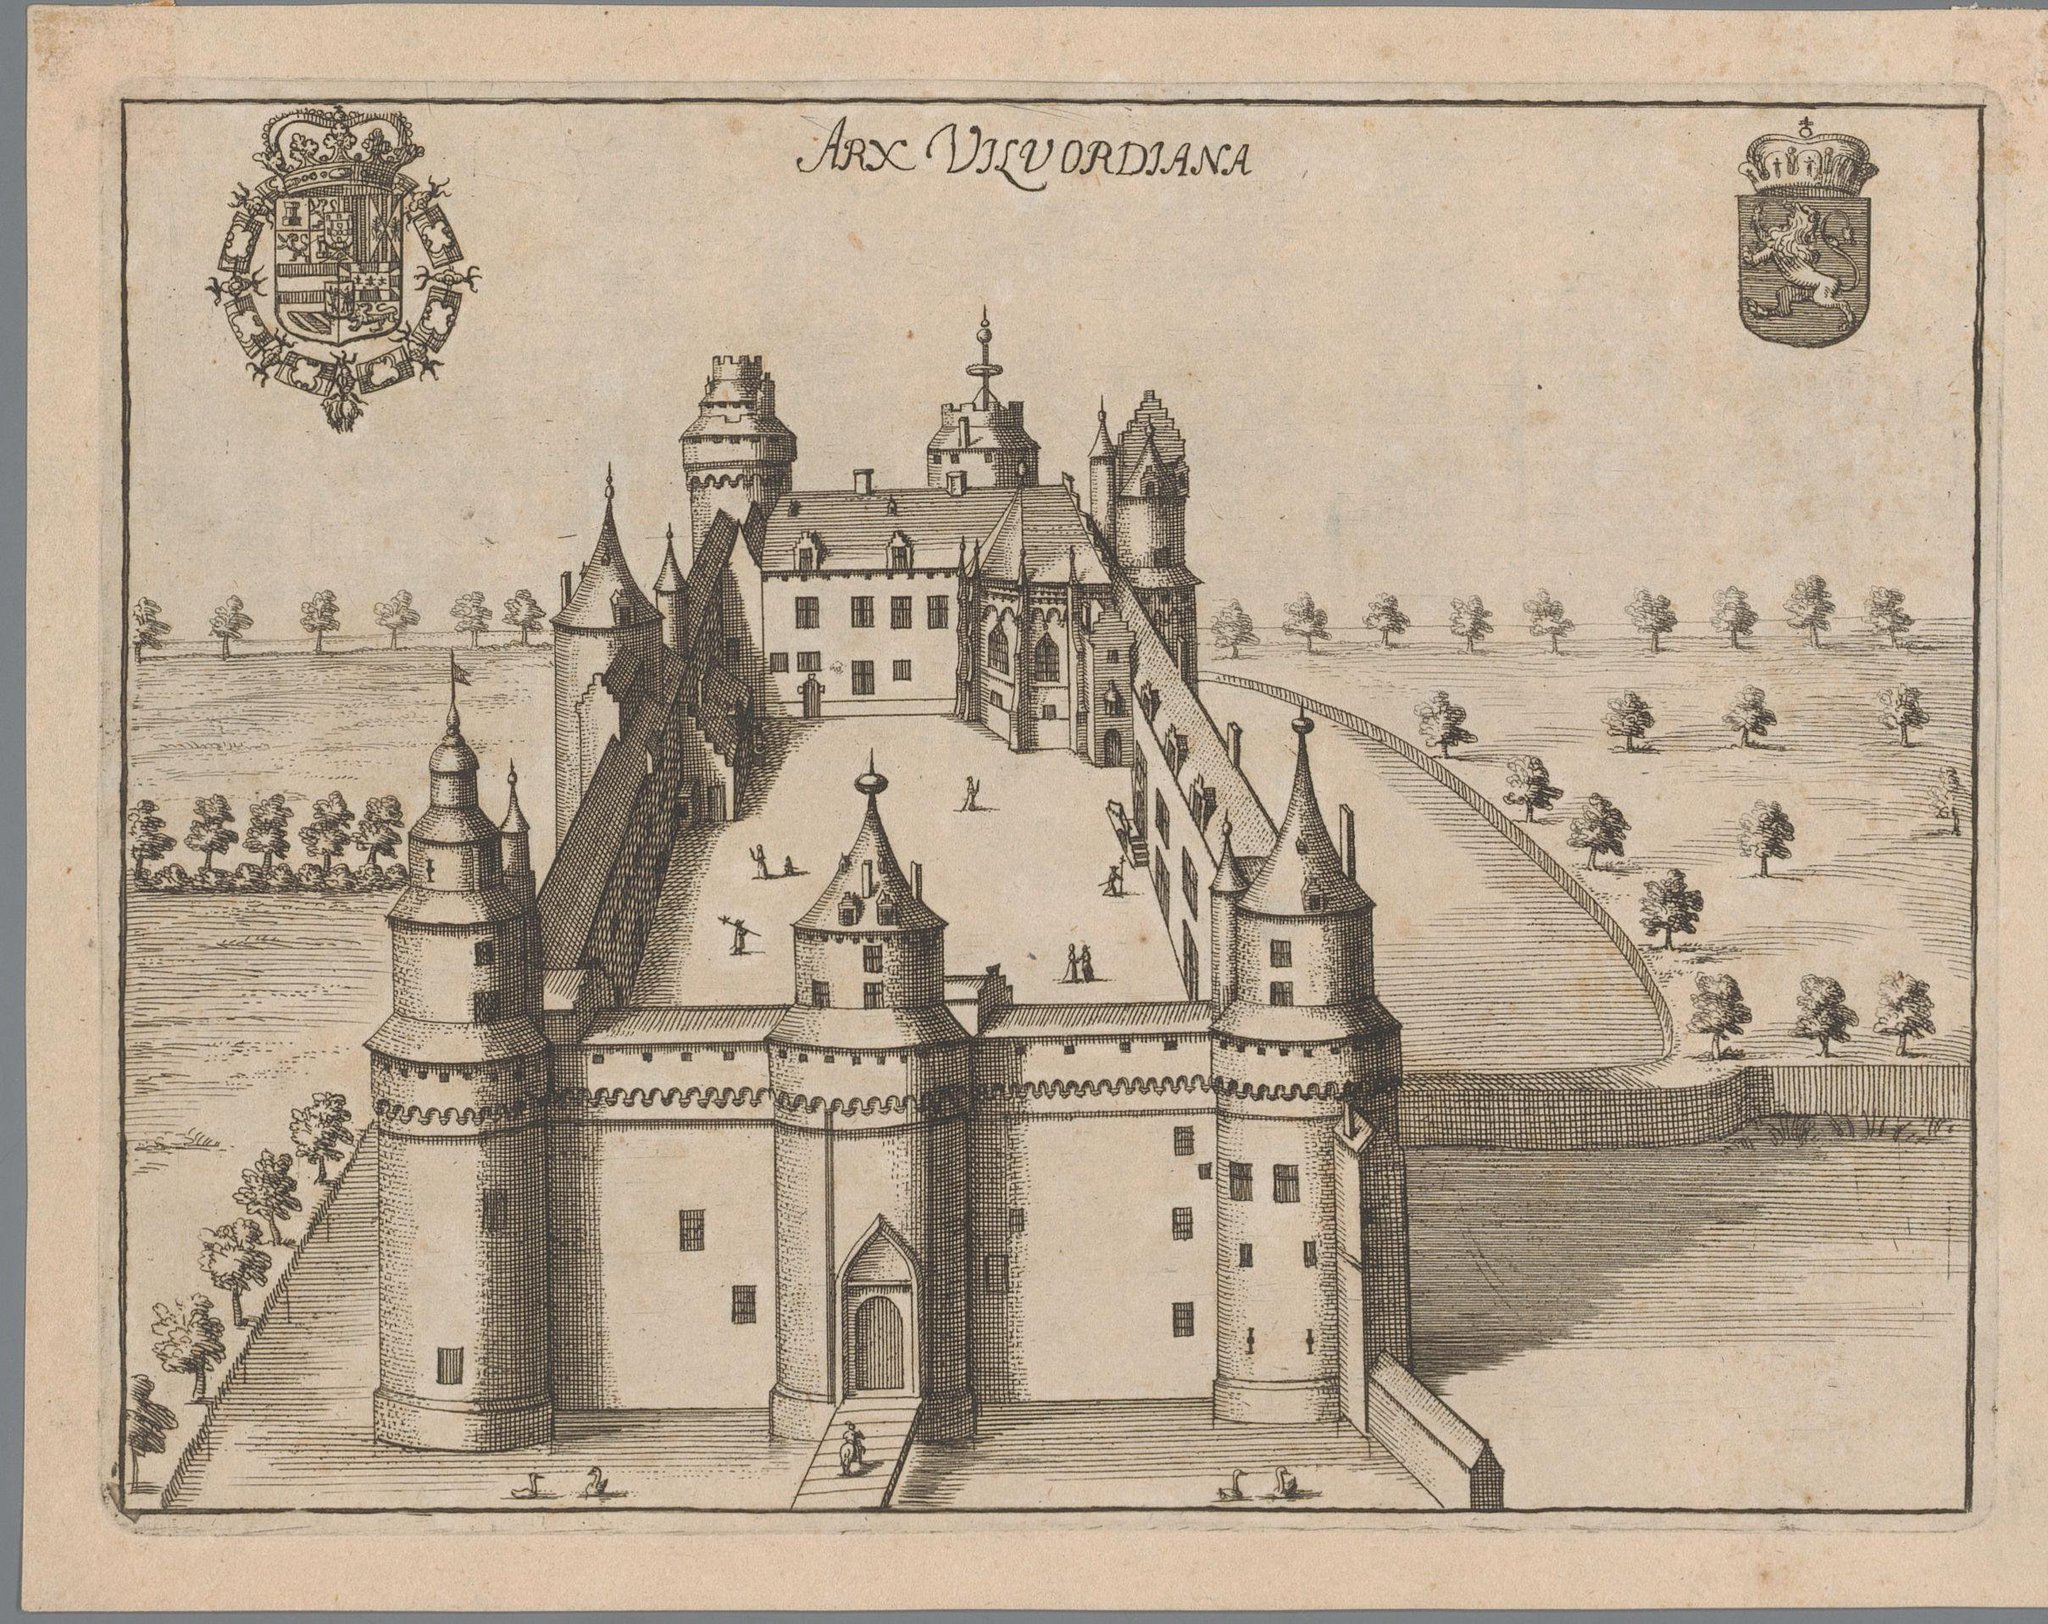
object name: print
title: Arx Vilvordiana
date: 1659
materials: paper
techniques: engraving, etching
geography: brussels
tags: landscape with tower or castle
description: Prent uit: Sanderus, Antonius. Presbyteri Chorographia sacra Brabantiae (...). Brussel: Philips Vleugaert, 1659.